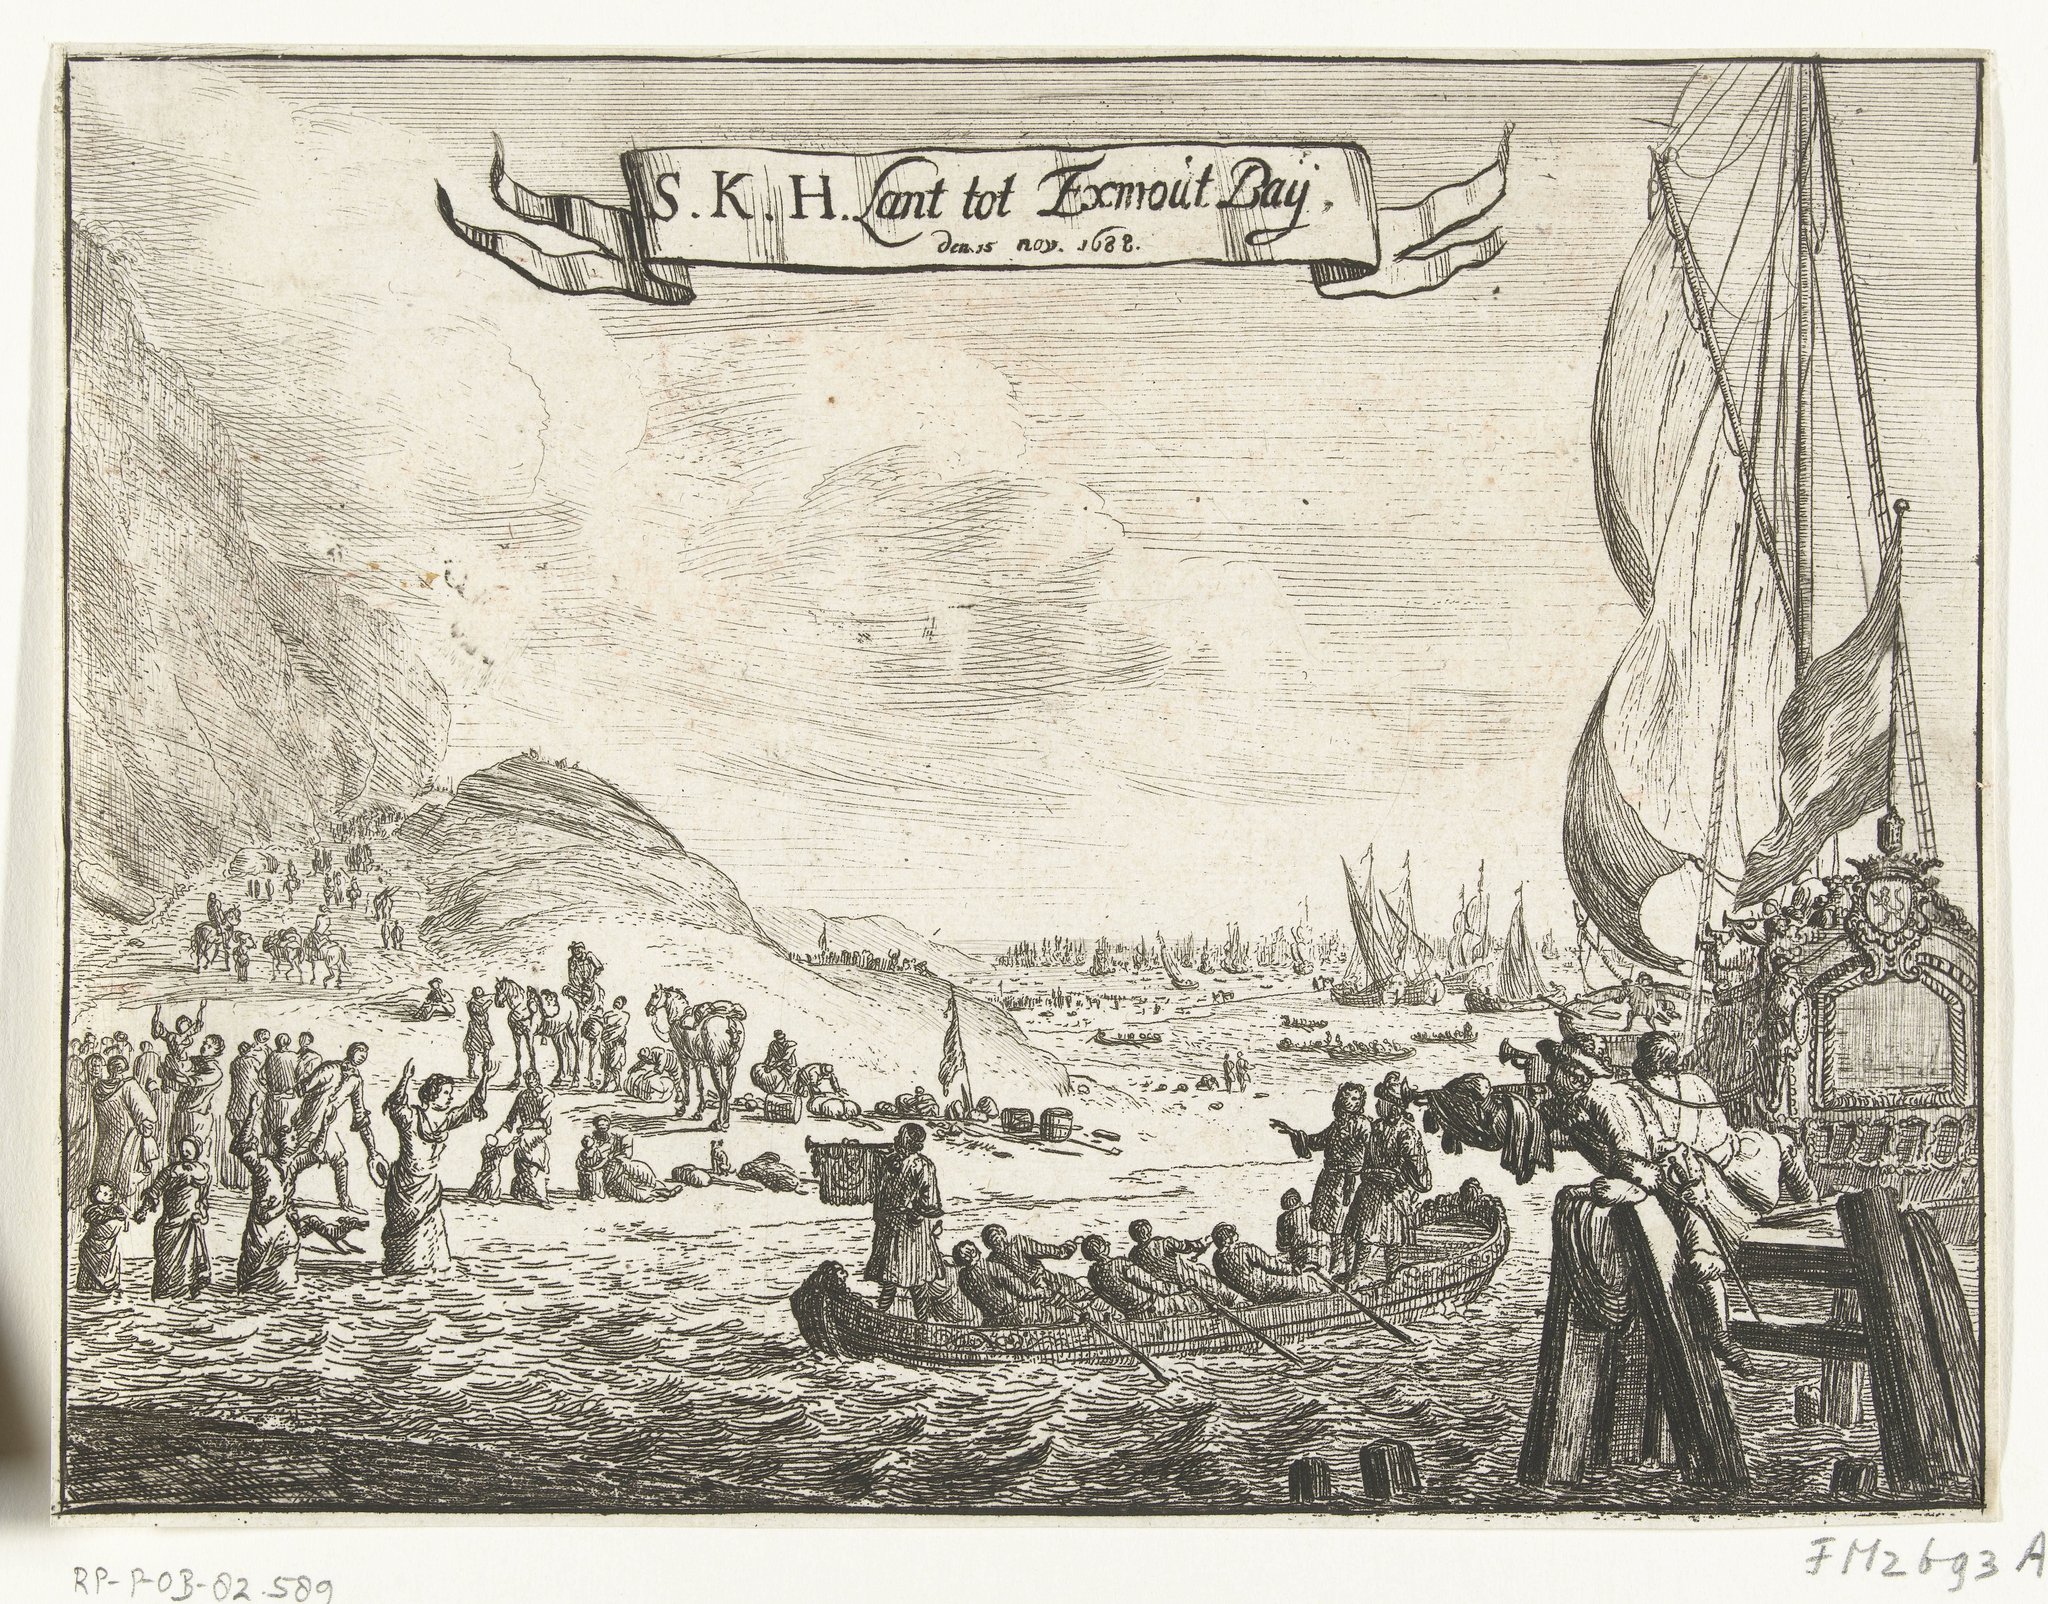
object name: print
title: Landing van de prins in Exmouth Bay, 1688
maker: Anonymous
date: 1688-1689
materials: paper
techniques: etching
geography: northern netherlands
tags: the hague, william iii (prince of orange and king of england, scotland, and ireland), warfare; military affairs (+ landing, disembarkation of armed forces)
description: Prins Willem III en zijn leger gaan bij het plaatsje Brixham aan land. De lokale bevolking loopt in het water om hem te begroeten, 15 november 1688.